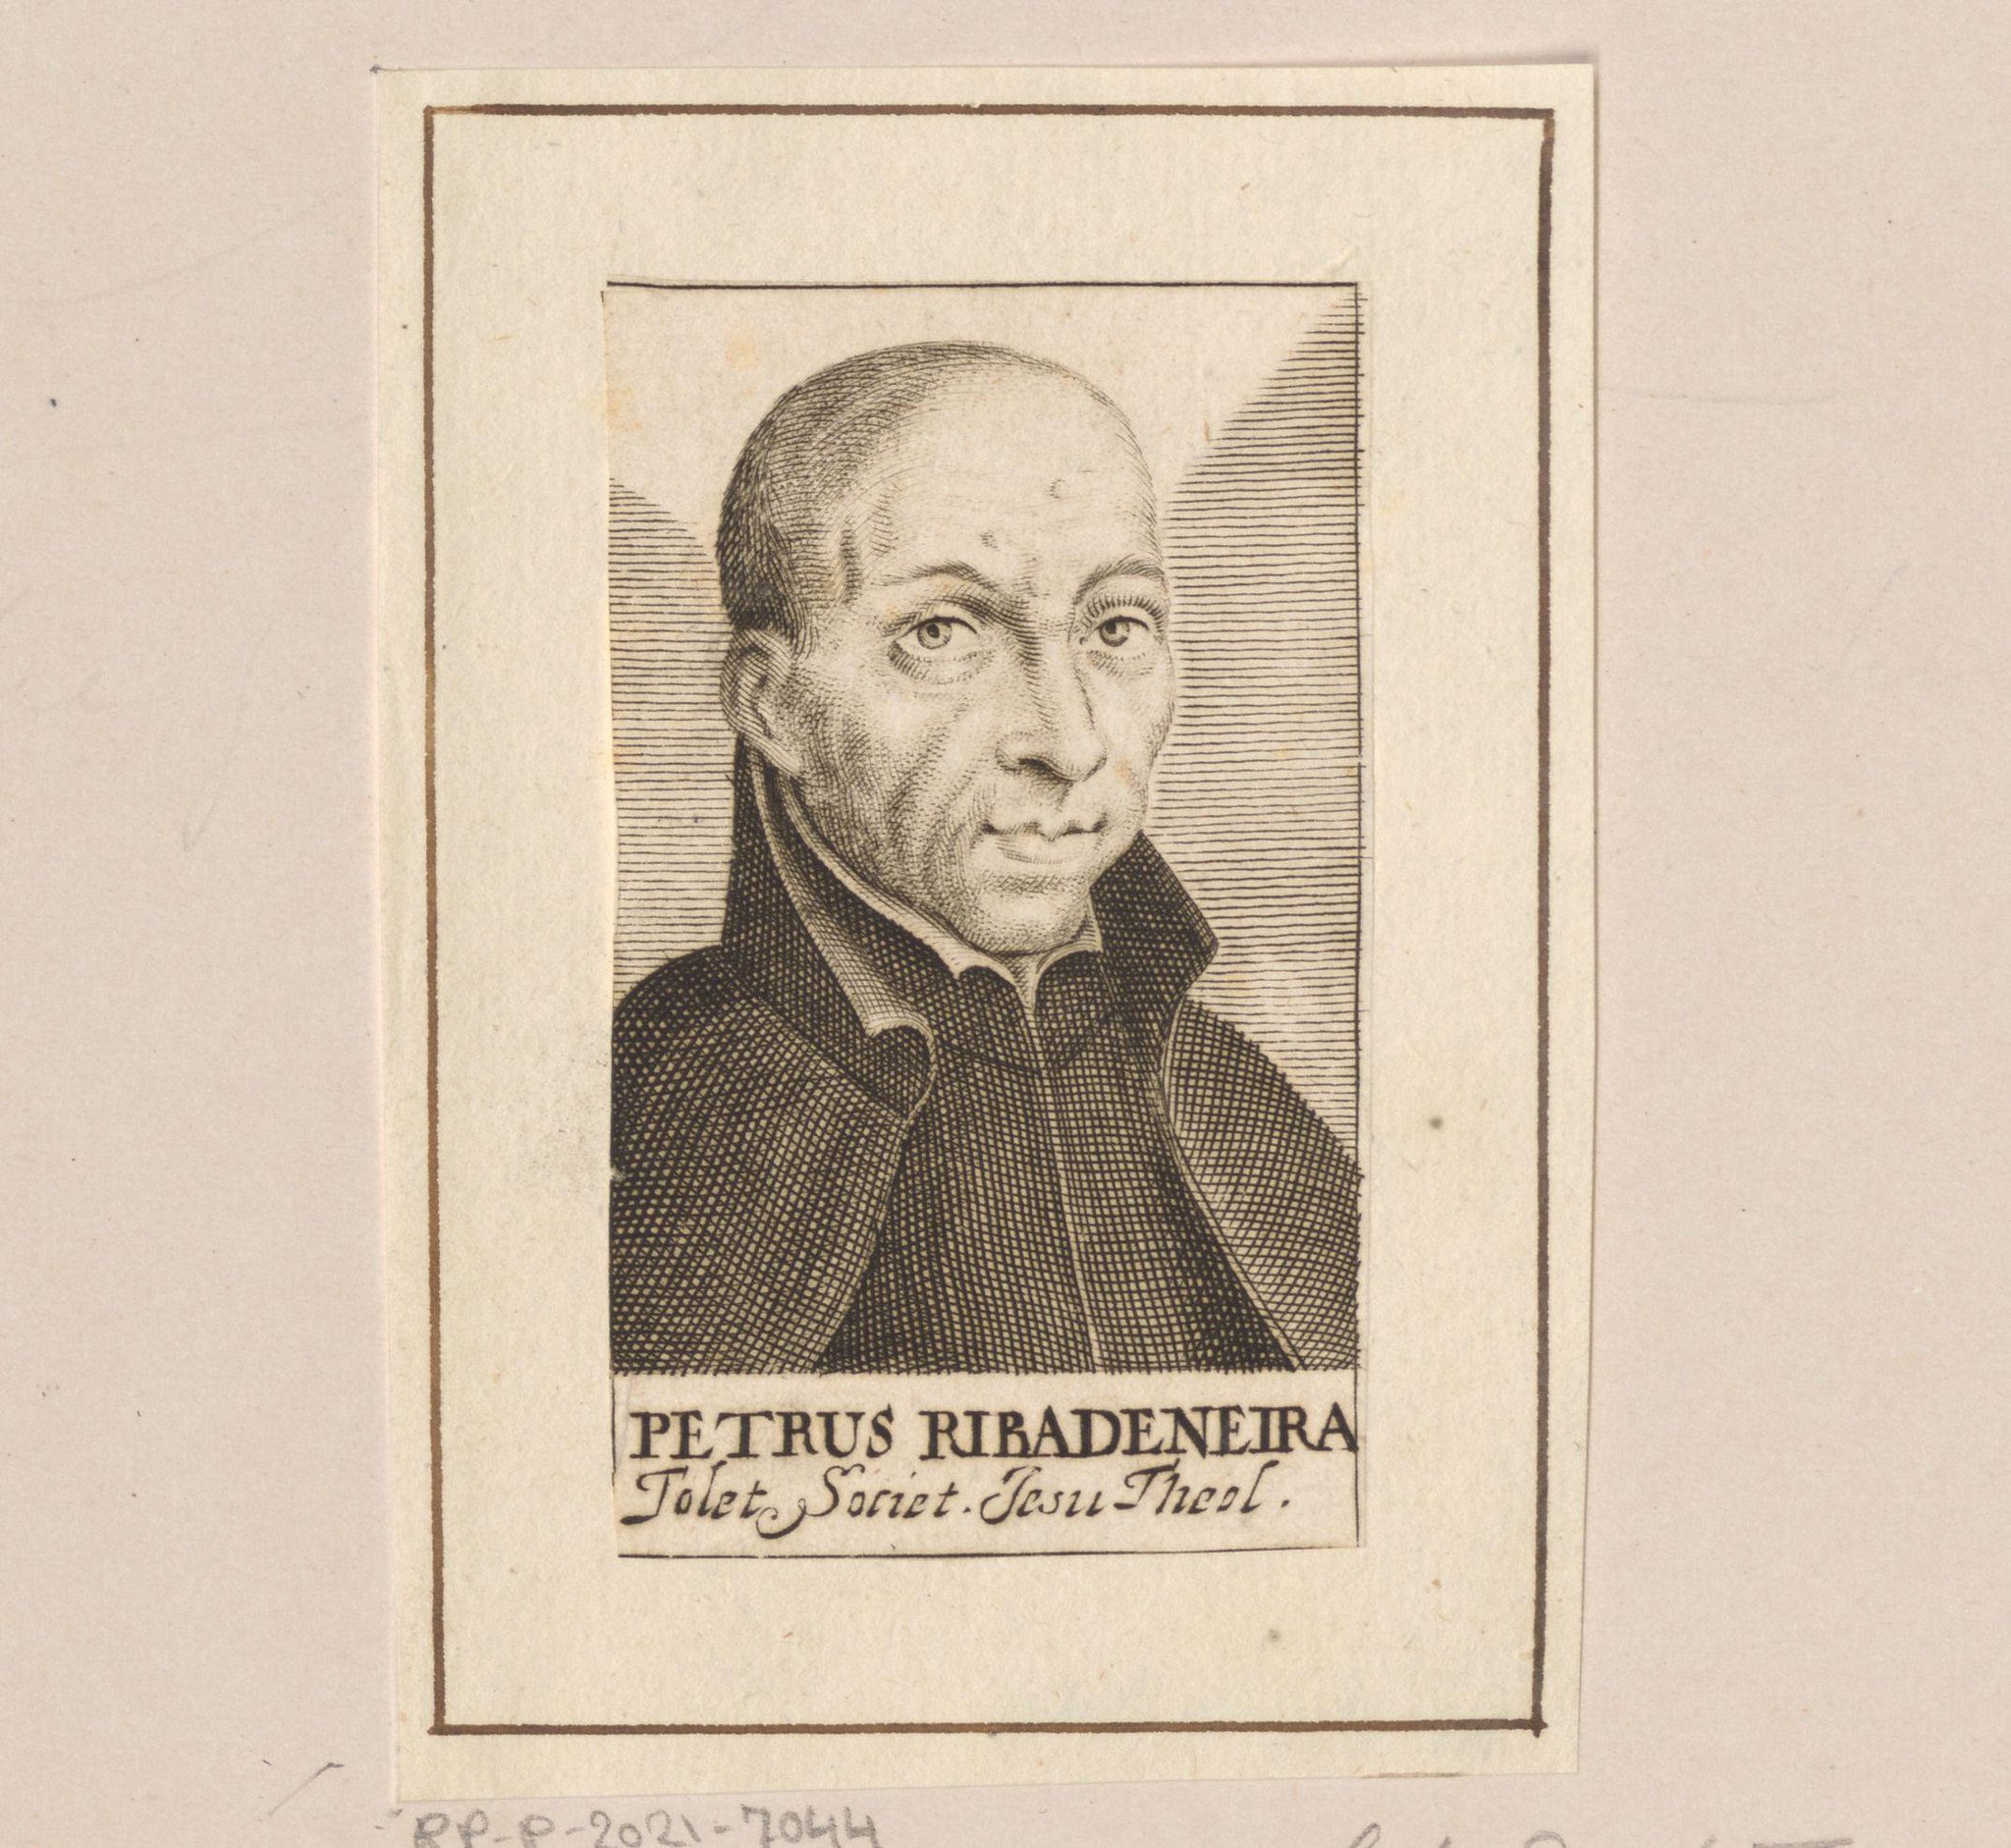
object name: print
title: Portret van Petrus Ribadineira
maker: Anonymous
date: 1688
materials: paper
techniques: engraving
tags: priest, petrus ribadineira, historical persons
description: Prent maakt deel uit van een grotere prent die later is verknipt. Prent waarschijnlijk uit: Freher, Paul. Theatrum virorum eruditione clarorum. Neurenberg: Johann Hoffmann, 1688.